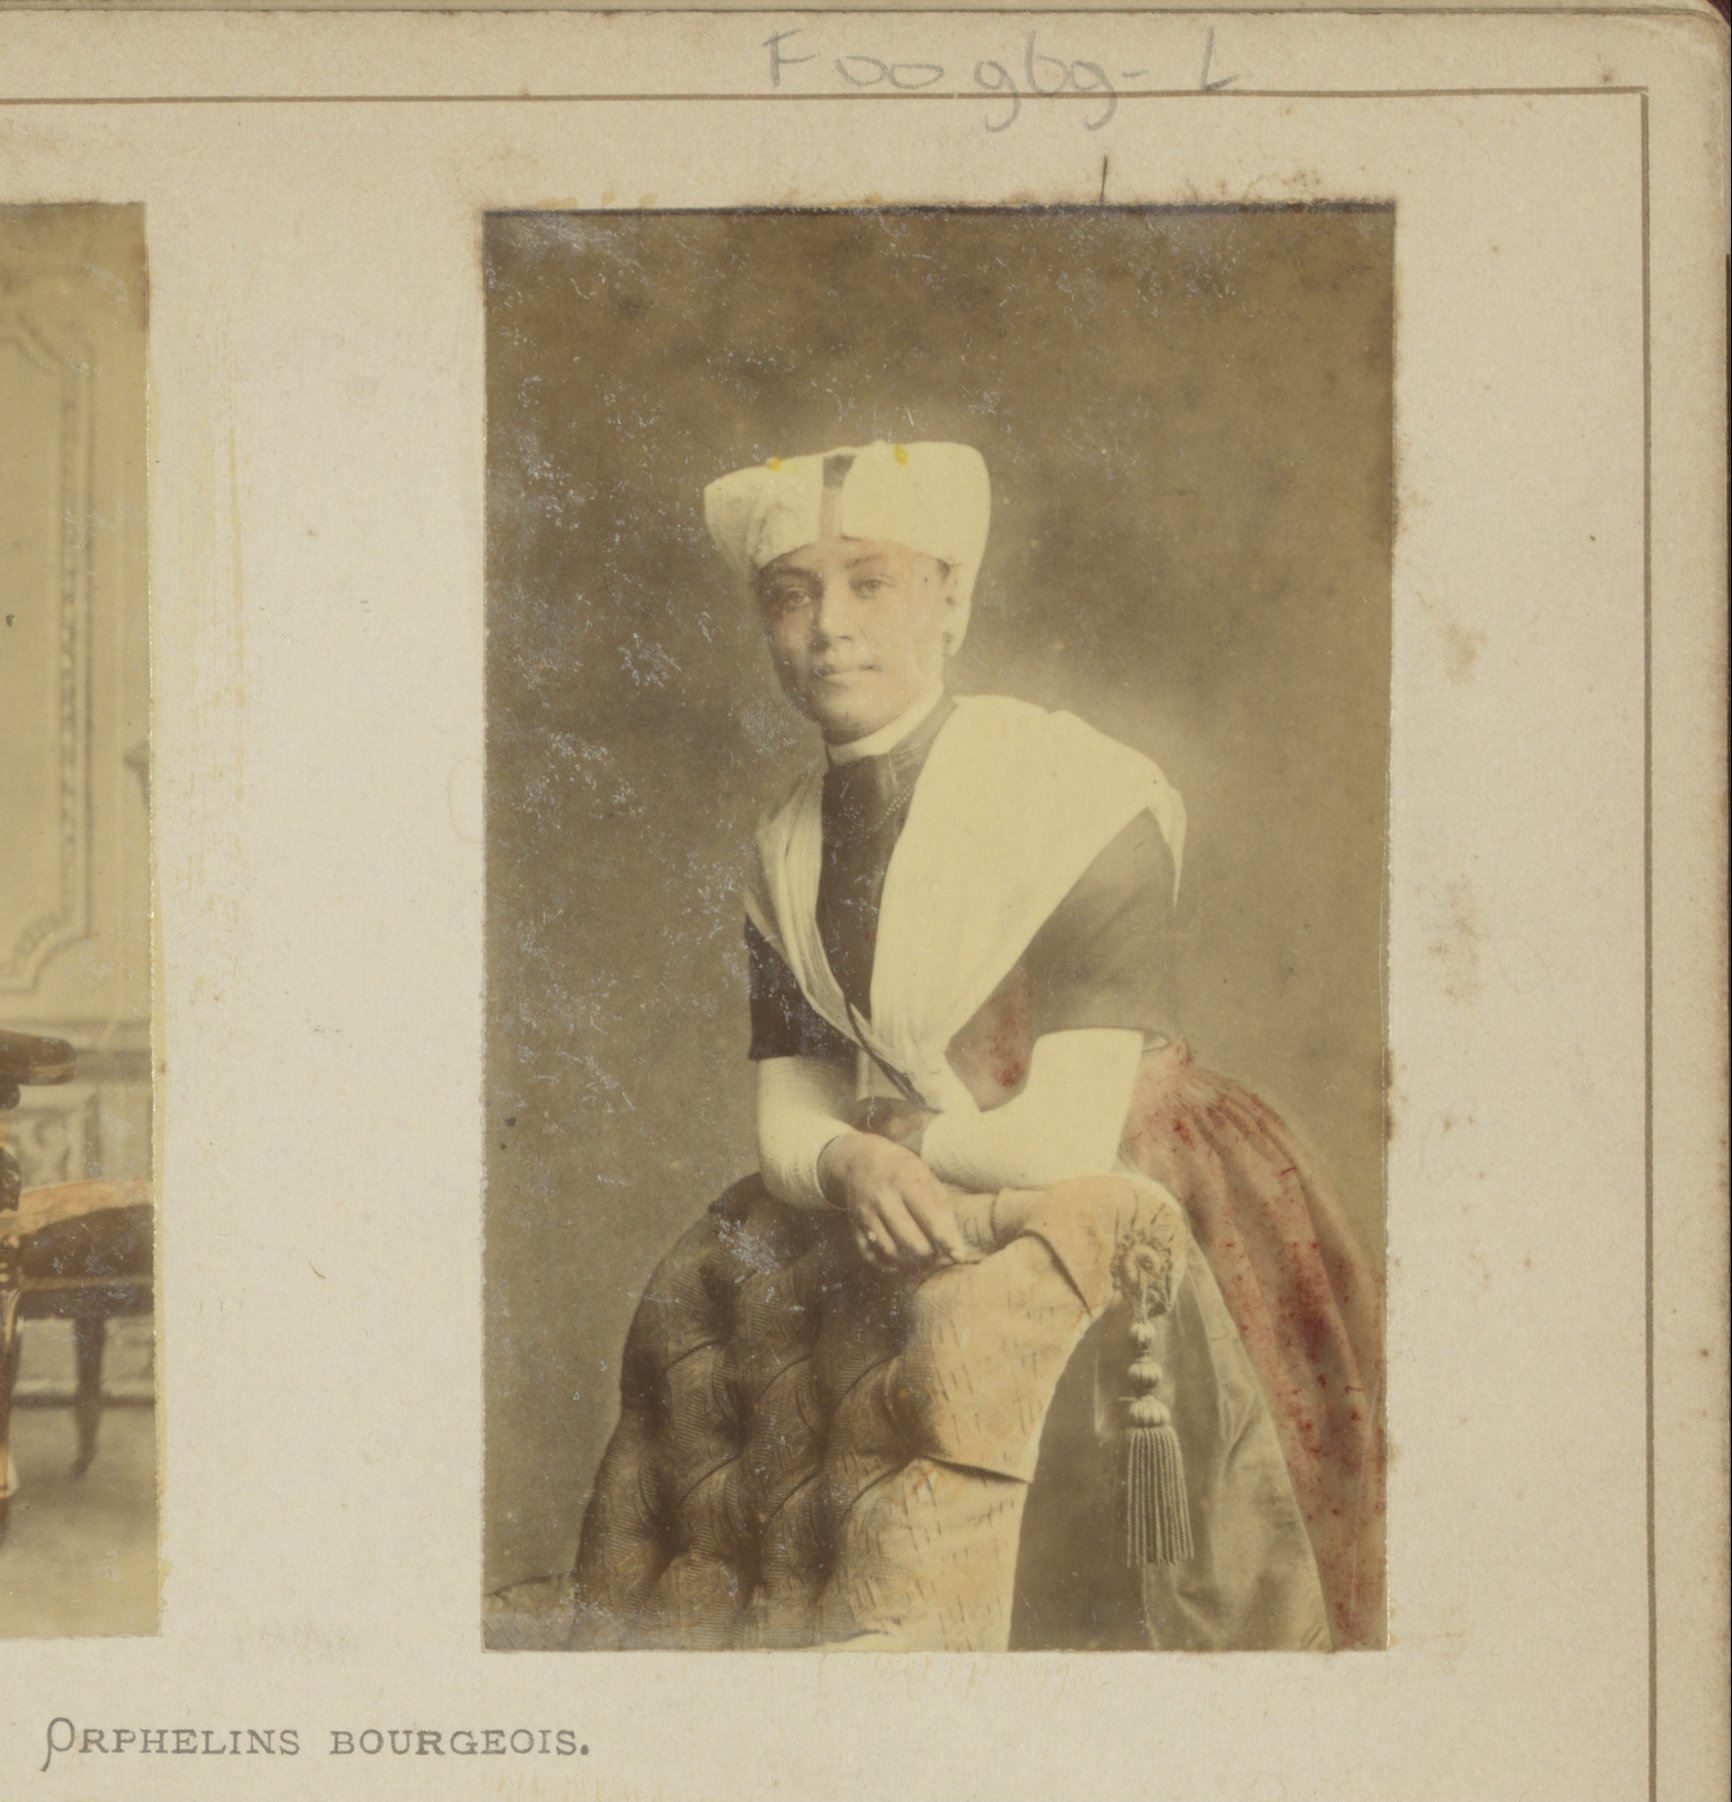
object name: photograph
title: Portret van een meisje in het uniform van het Burgerweeshuis te Amsterdam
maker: andries jager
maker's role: publisher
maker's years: 1825-1905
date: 1875-1910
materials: cardboard, paper, photographic support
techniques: albumen print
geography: amsterdam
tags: studio requisites ~ photographer, neck-gear ~ clothing, head-gear: cap, clothes covering the entire body, (military) uniforms, orphans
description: Onderdeel van Leporelloalbum met 28 foto's van Amsterdam en omstreken.